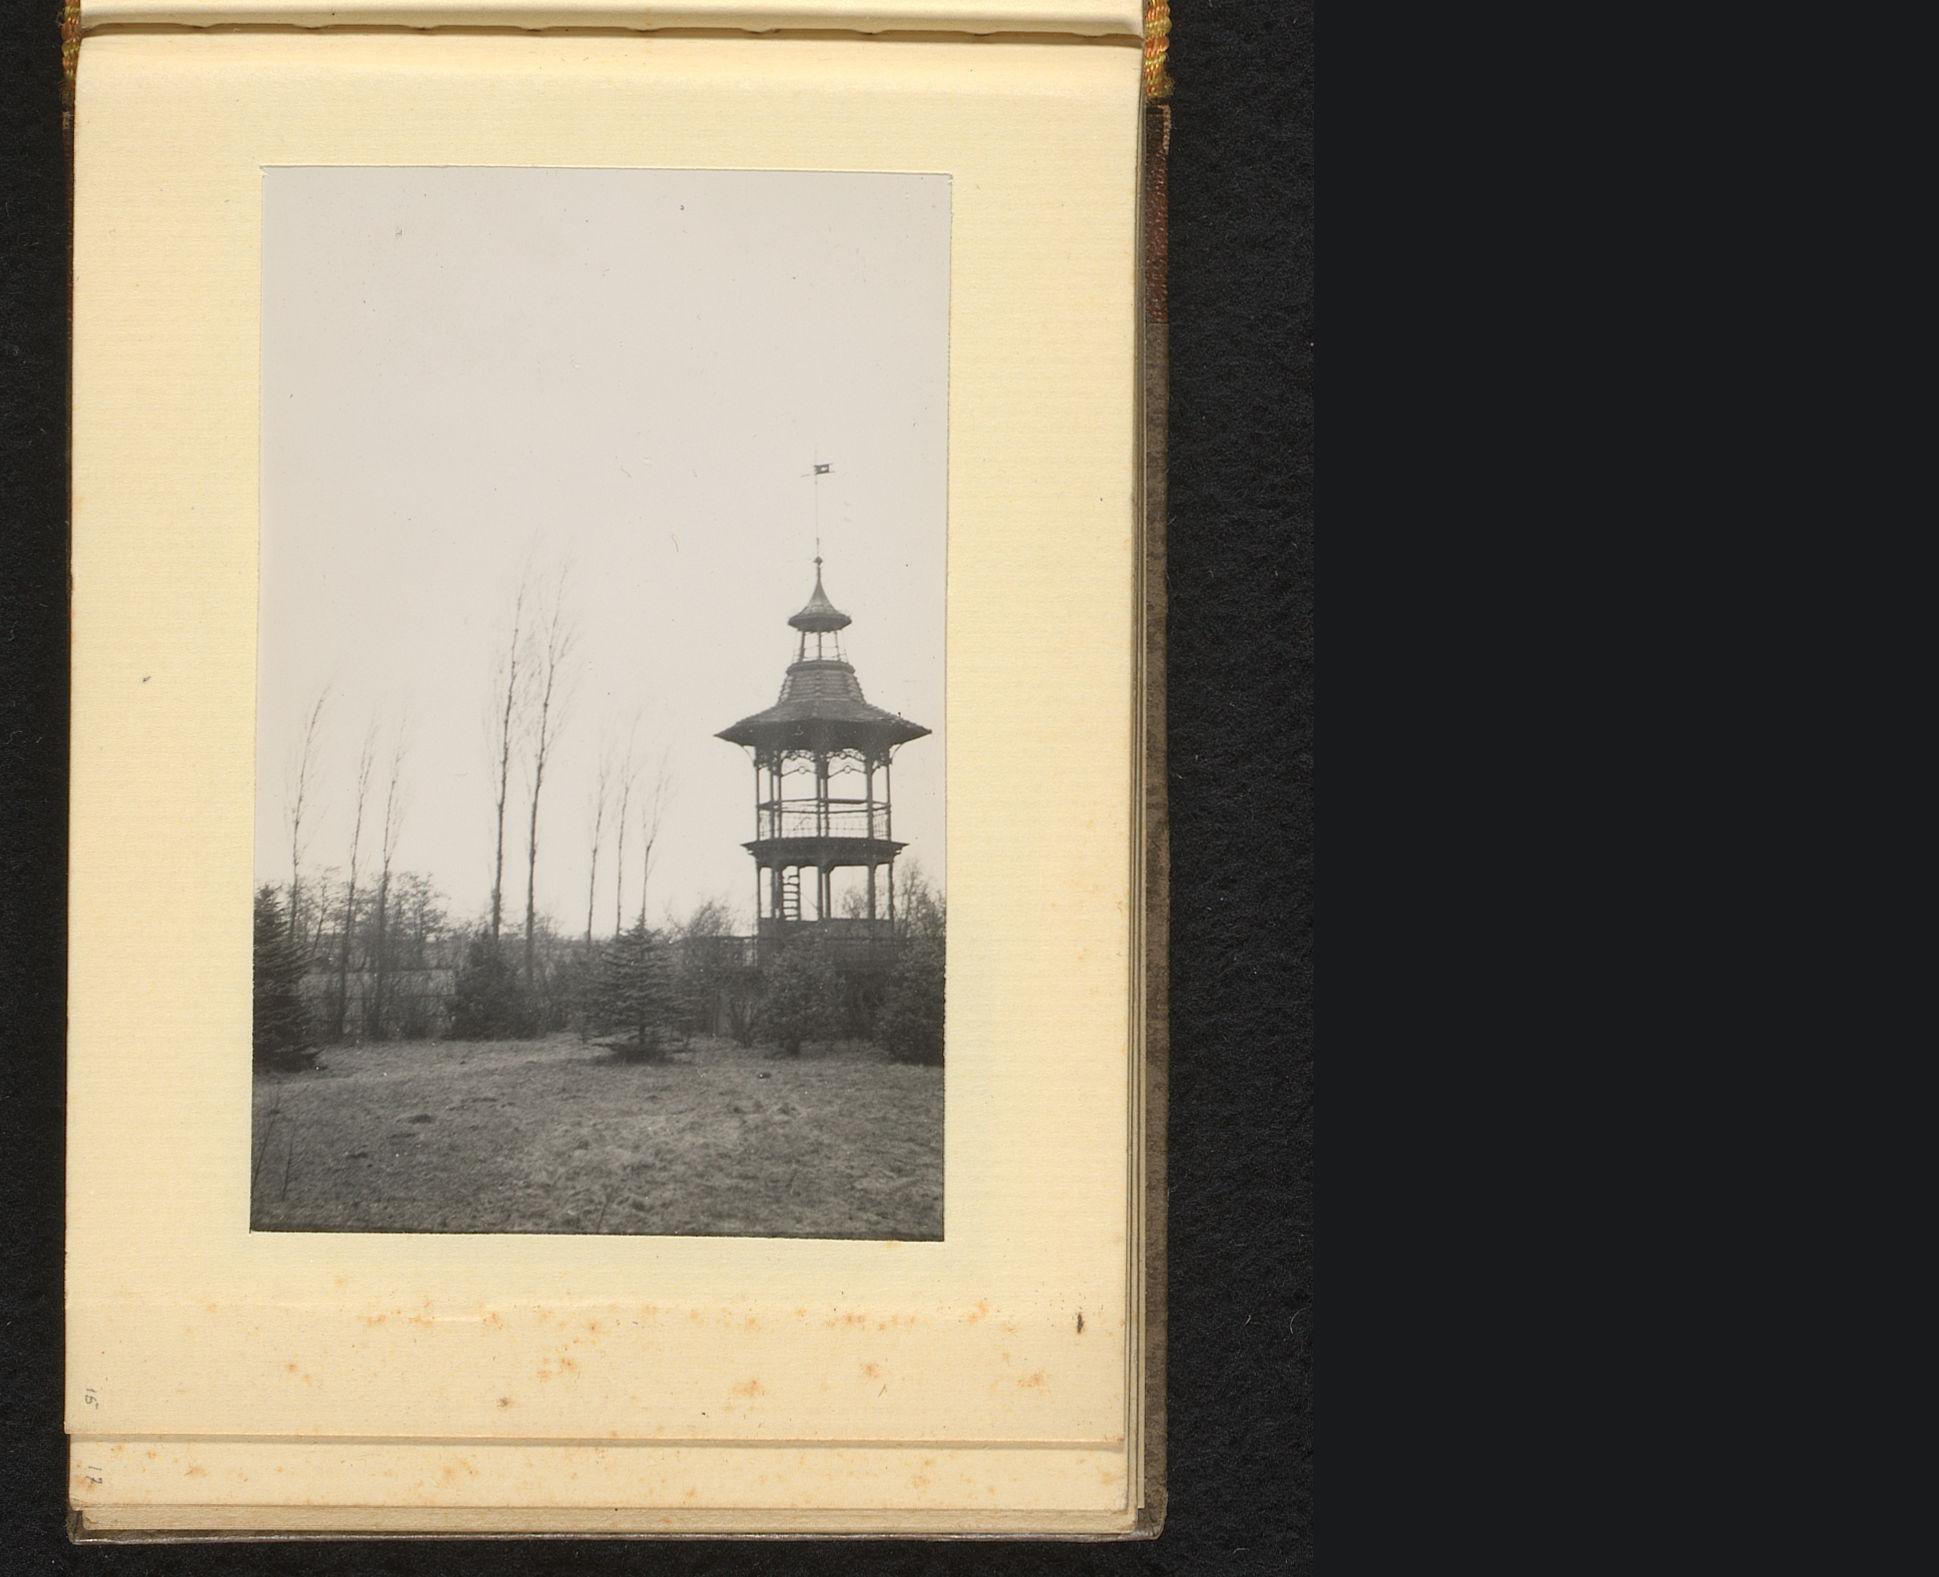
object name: album leaf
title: Uitkijktoren in landschap met bomen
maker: norbert van den berg (1901-1972)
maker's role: amateurfotograaf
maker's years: 1901-1972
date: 1935-1950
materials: paper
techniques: gelatin silver print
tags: landscape with tower or castle